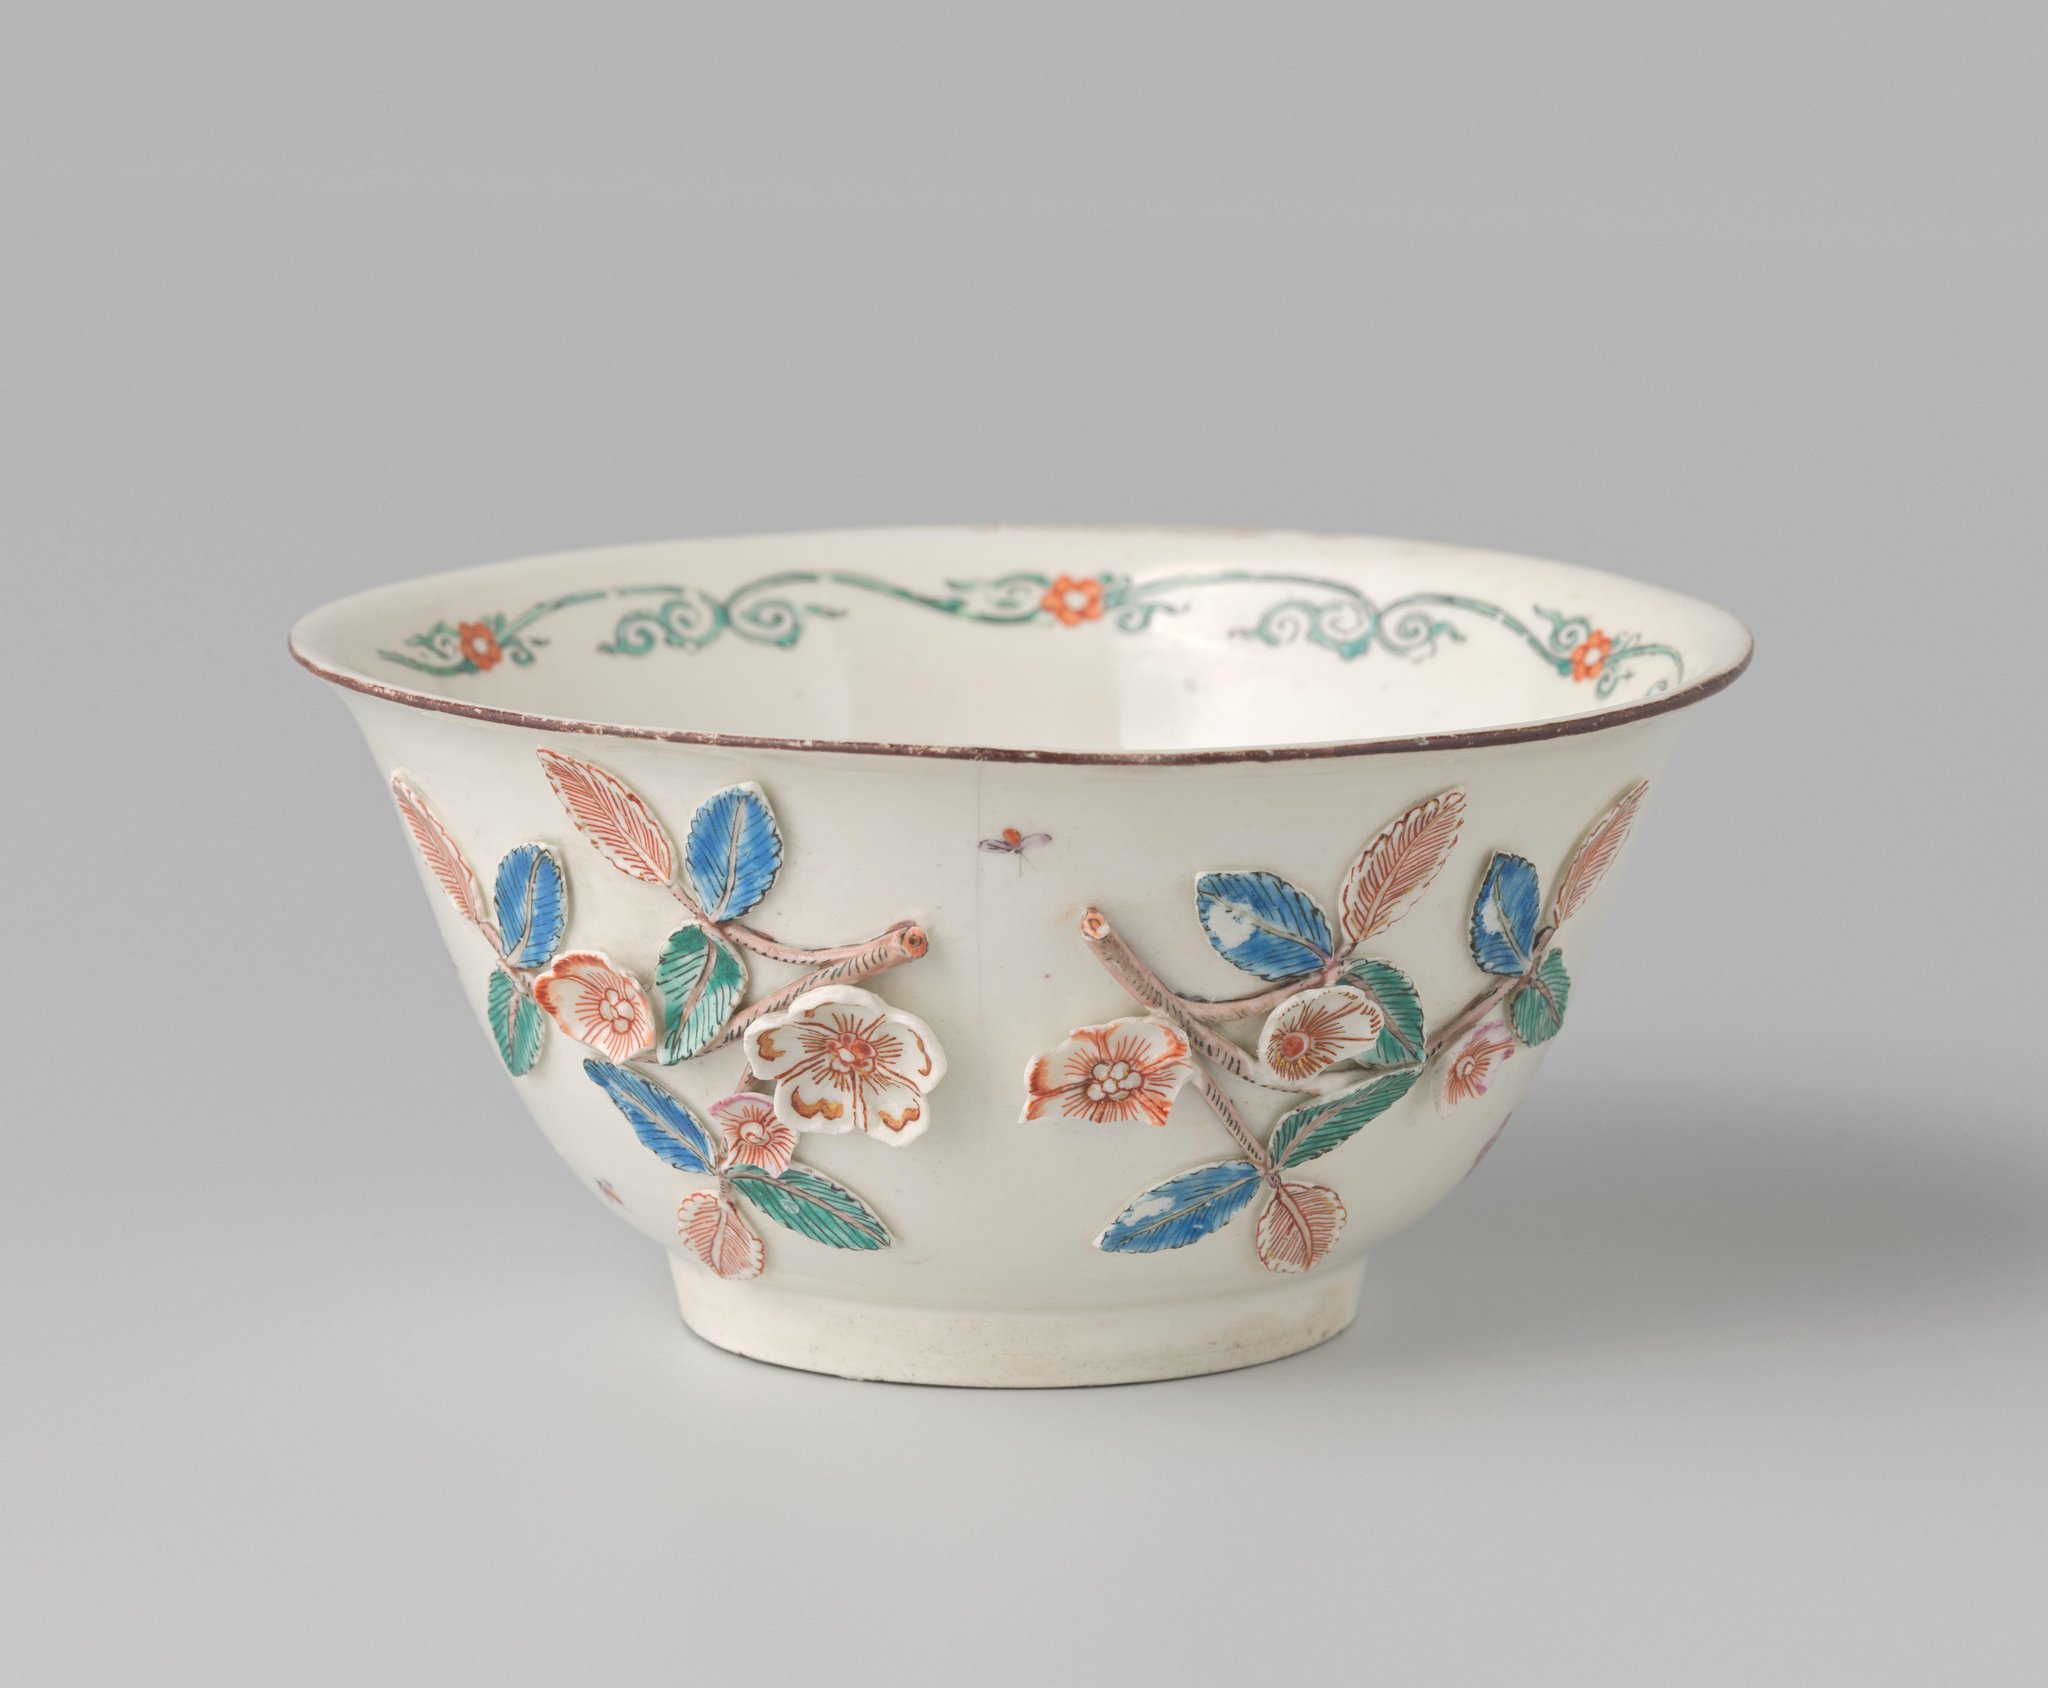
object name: eating drinking utensil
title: Spoelkom, gedecoreerd met rozentakken in reliëf, veelkleurig beschilderd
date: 1715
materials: porcelain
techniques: painted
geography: meissen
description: Slop basin. Meissen, c. 1715, decorated in the Netherlands, c. 1730.